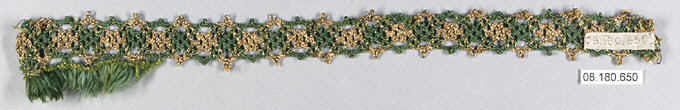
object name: passementerie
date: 1601-1700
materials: metal thread, silk